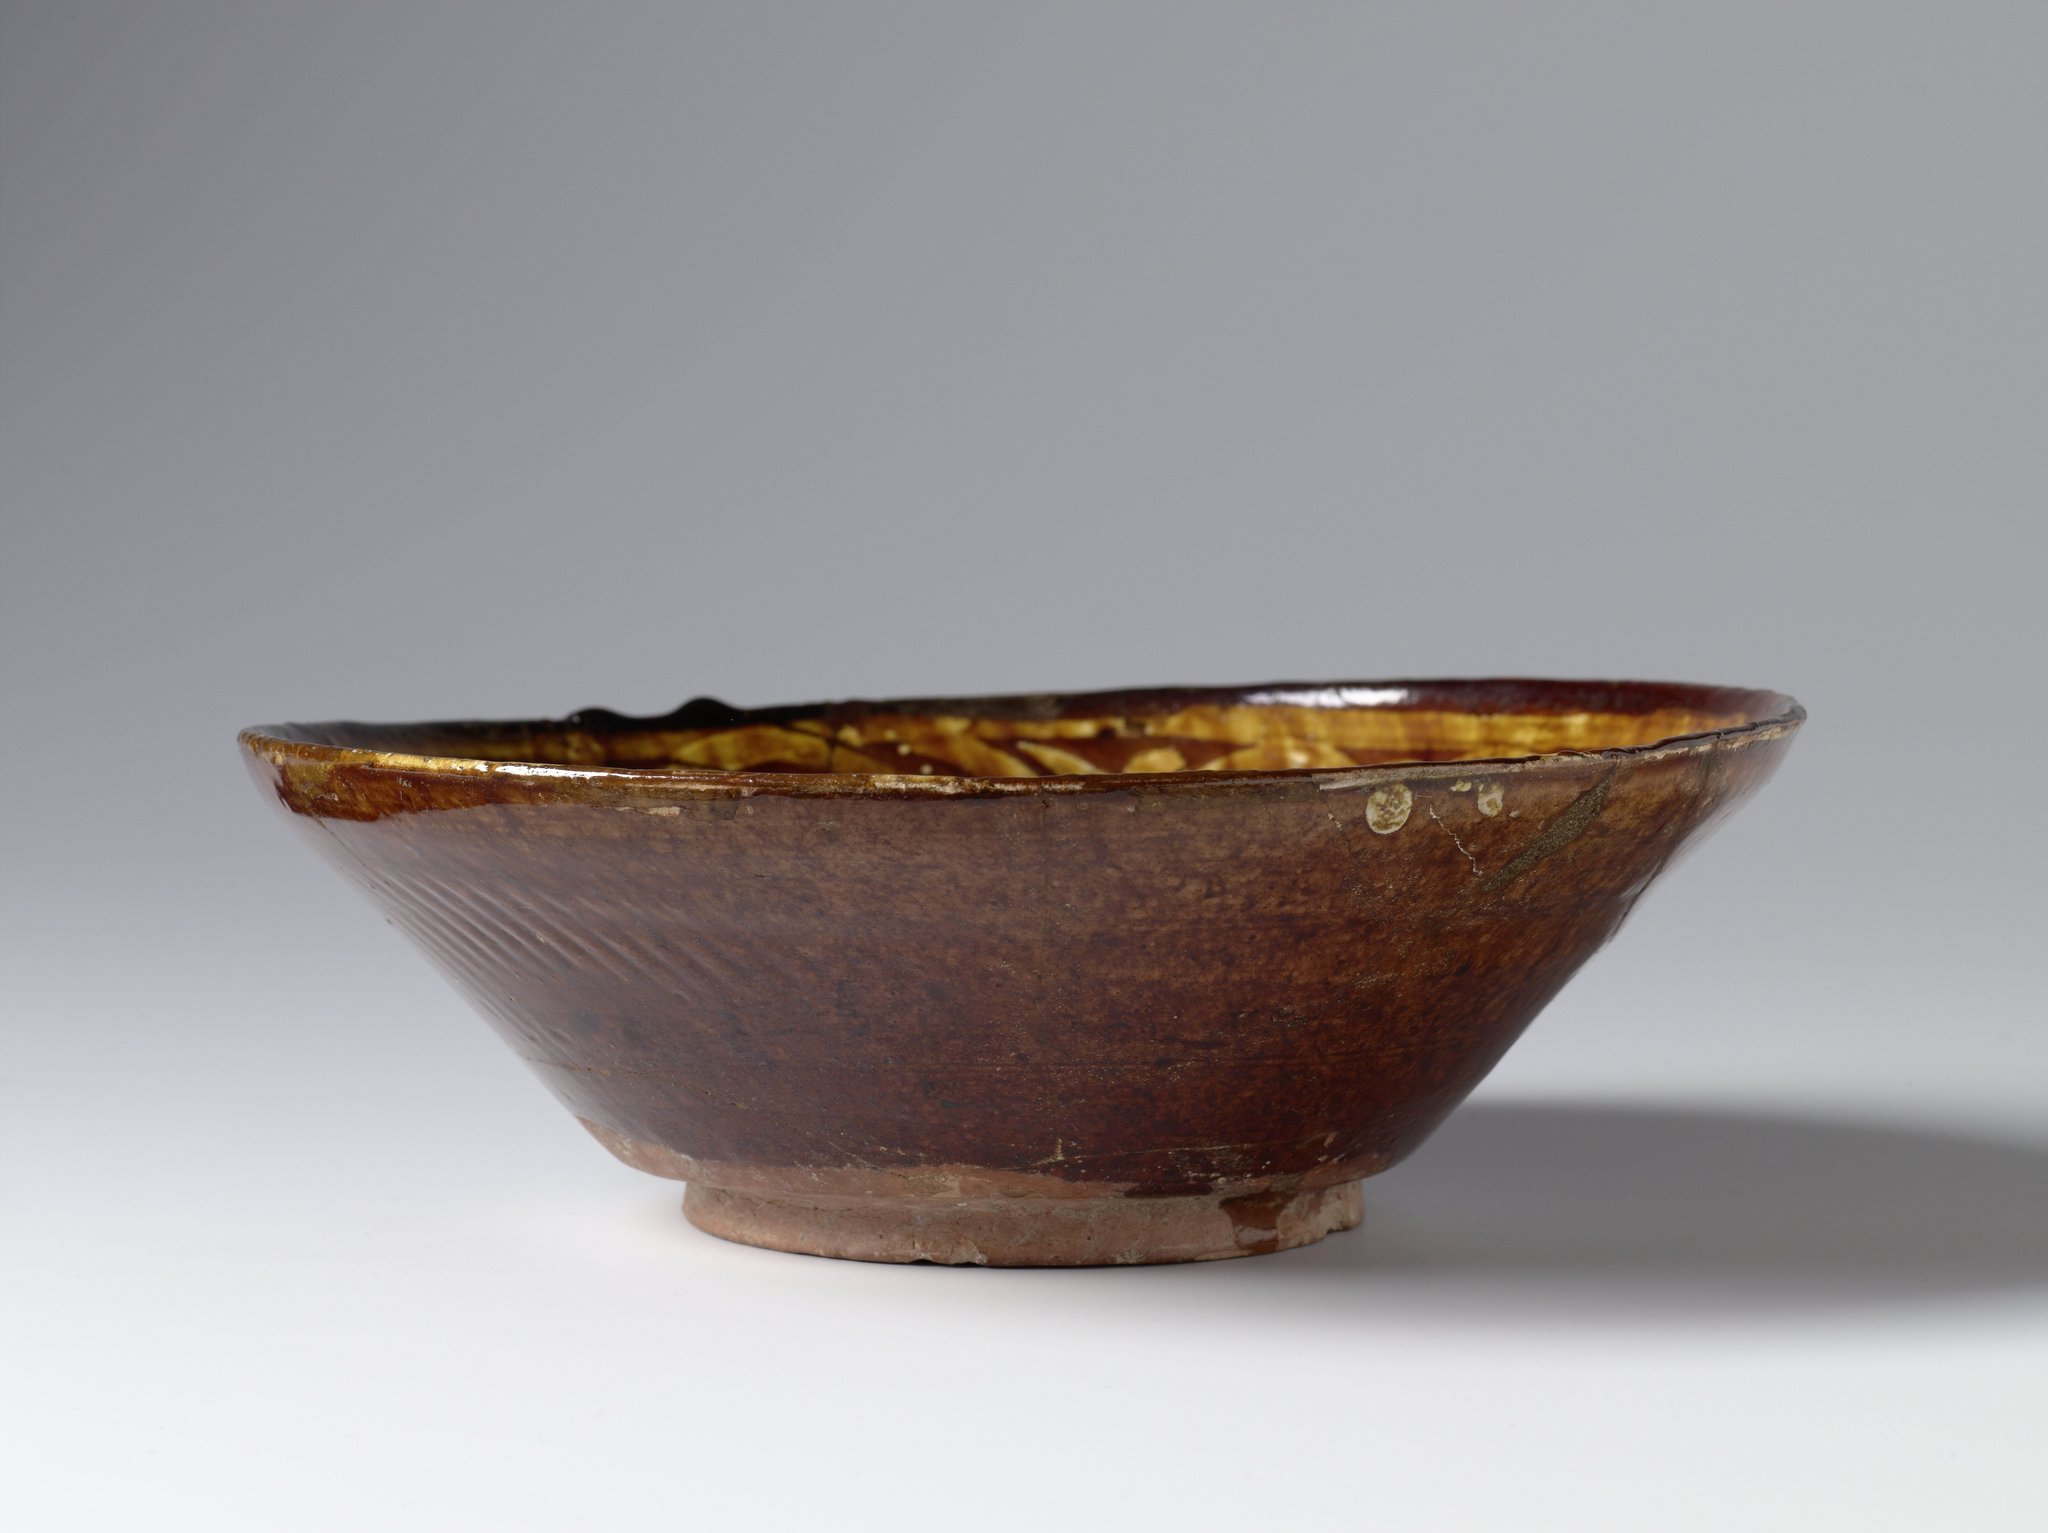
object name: bowl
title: bowl with a stylised duck among floral scrolls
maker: Anonymous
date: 1100-1299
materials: earthenware, glaze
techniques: cutting, firing, turning, vitrification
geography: garrus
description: Kom van aardewerk bedekt met engobe van witte slib waaruit de decoratie is gesneden. Op de bodem een eend; de binnenwand met een brede band bloemranken.